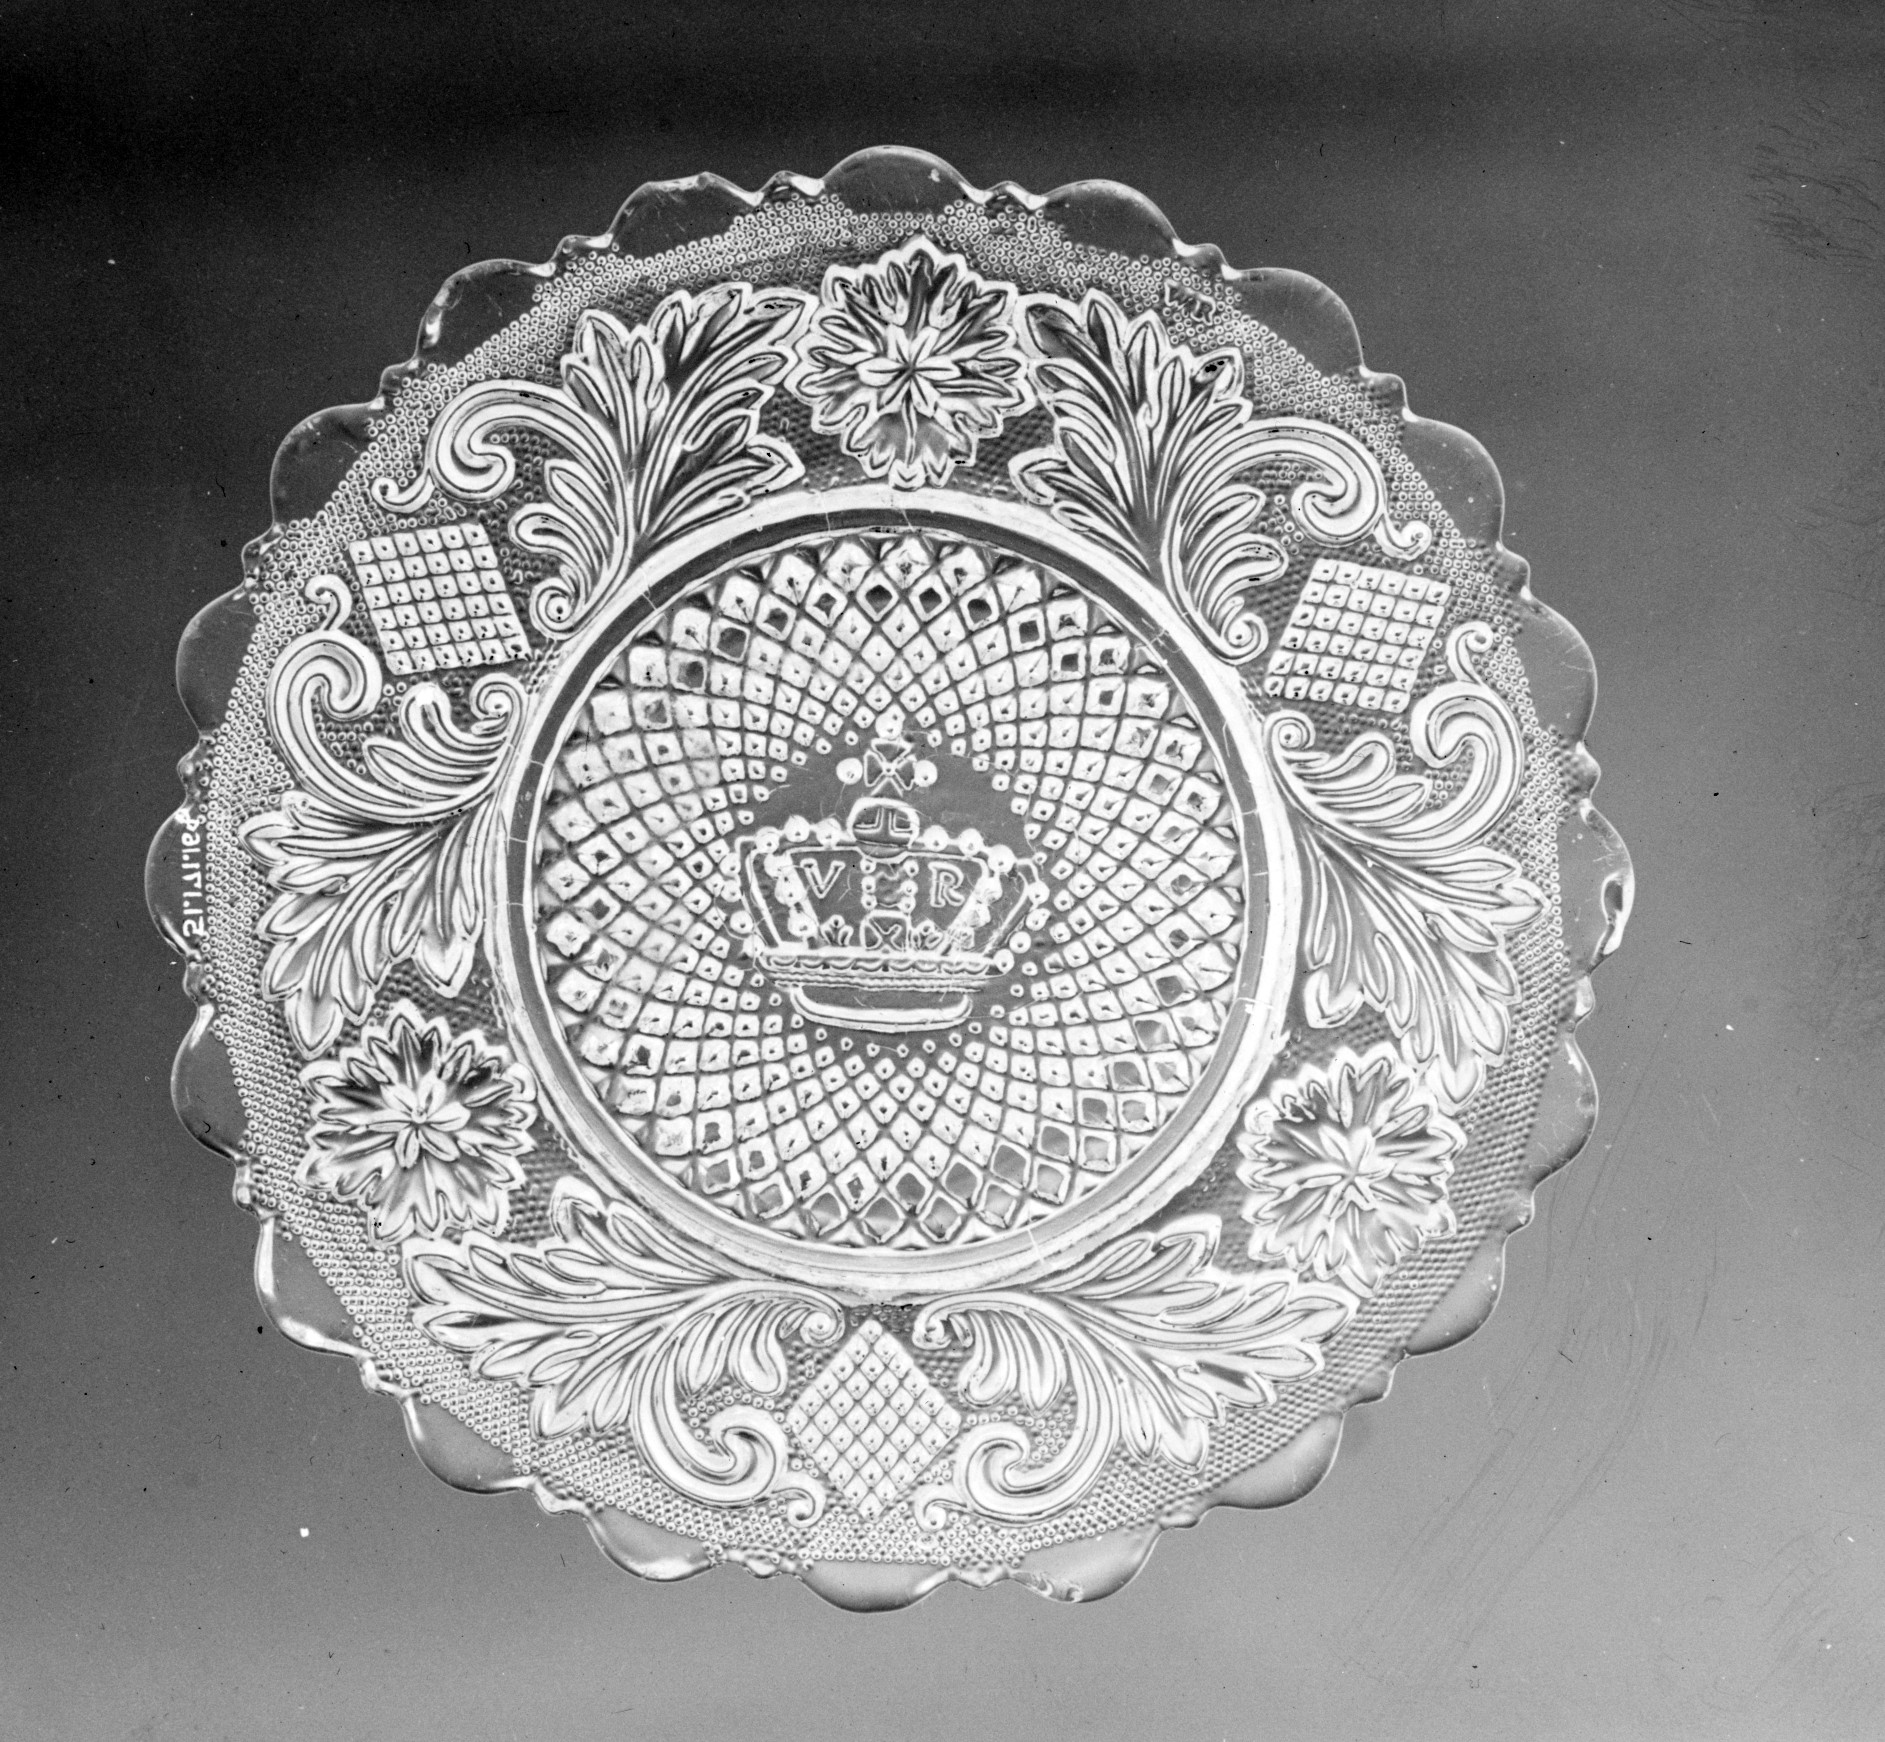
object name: plate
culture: american or british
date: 1837-1840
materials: glass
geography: england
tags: crowns